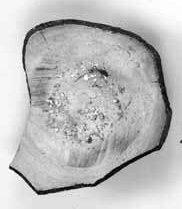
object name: shard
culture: korean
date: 1401-1500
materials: pottery